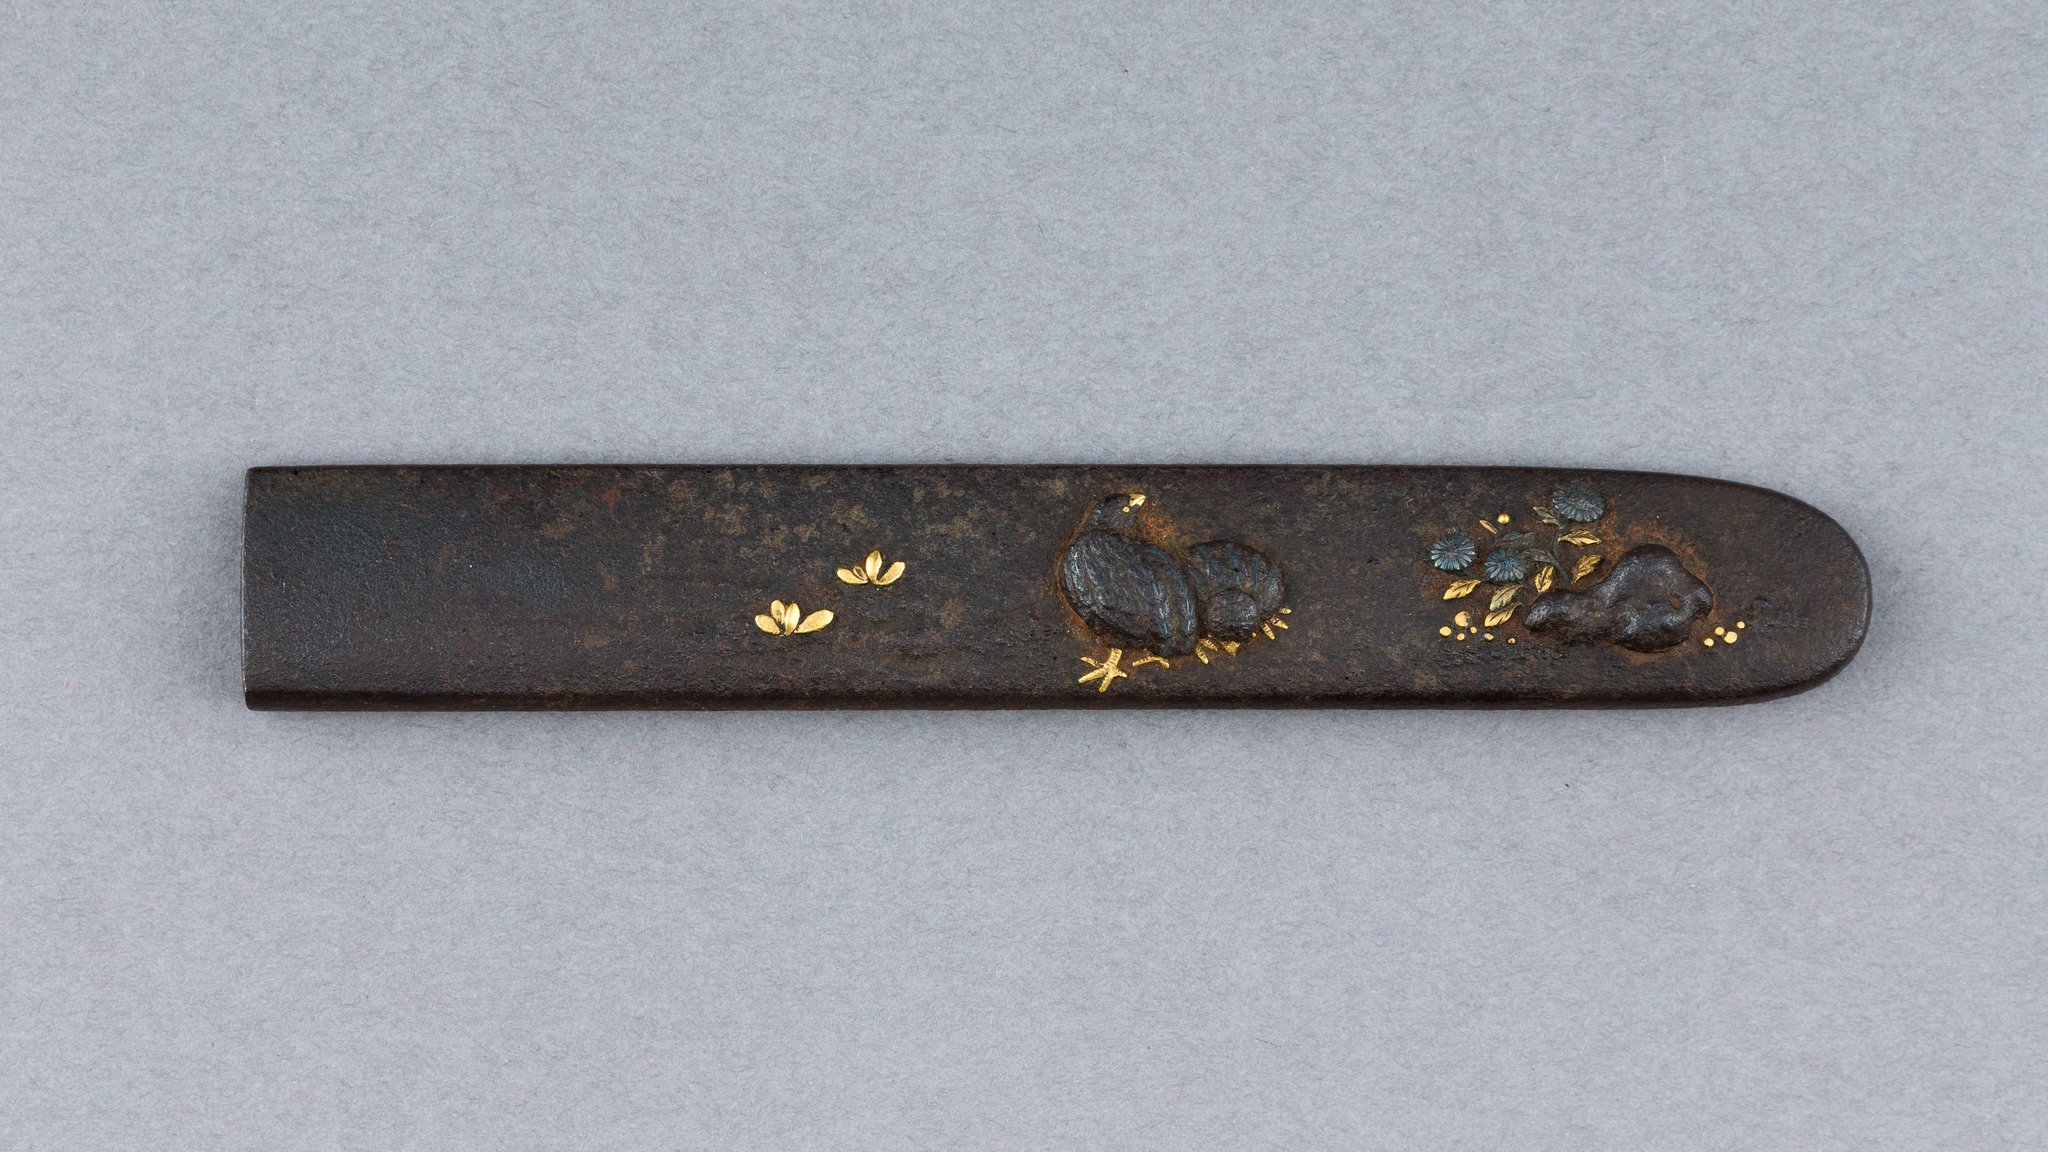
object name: knife handle kozuka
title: Knife Handle (Kozuka)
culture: japanese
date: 1615-1868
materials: gold alloy, gold, iron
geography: japan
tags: birds